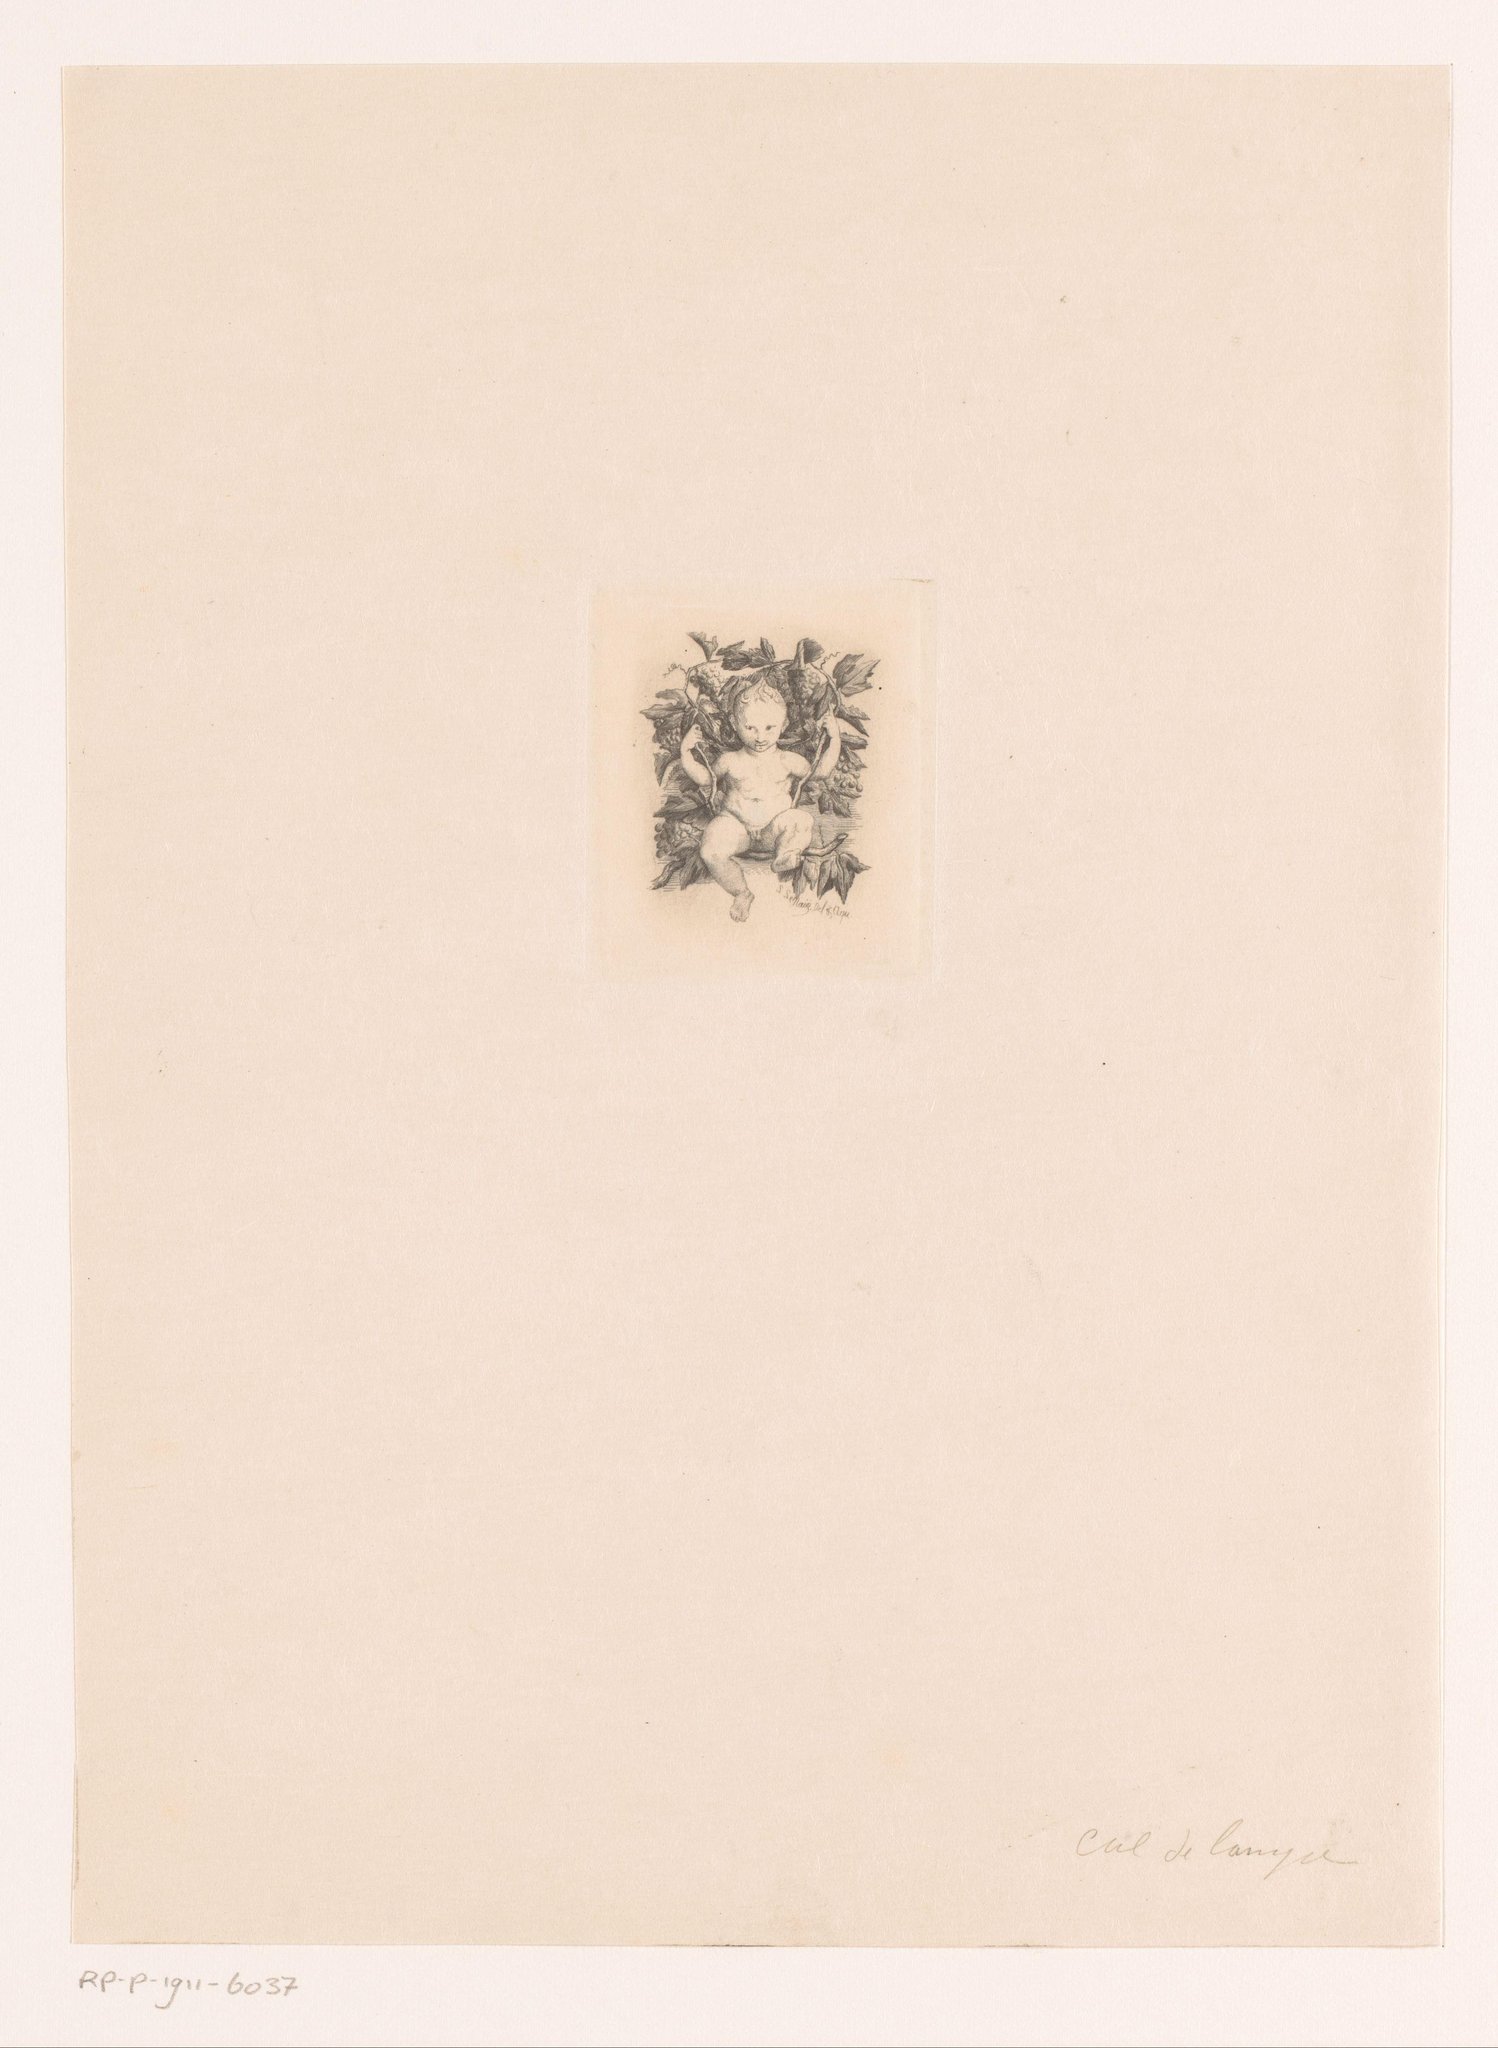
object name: print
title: Putto omringd door druivenranken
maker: louis le nain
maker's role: print maker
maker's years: 1851-1939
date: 1861-1911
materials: paper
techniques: etching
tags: vine, cupids: 'amores', 'amoretti', 'putti'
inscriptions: collector's mark: Lugt 2228